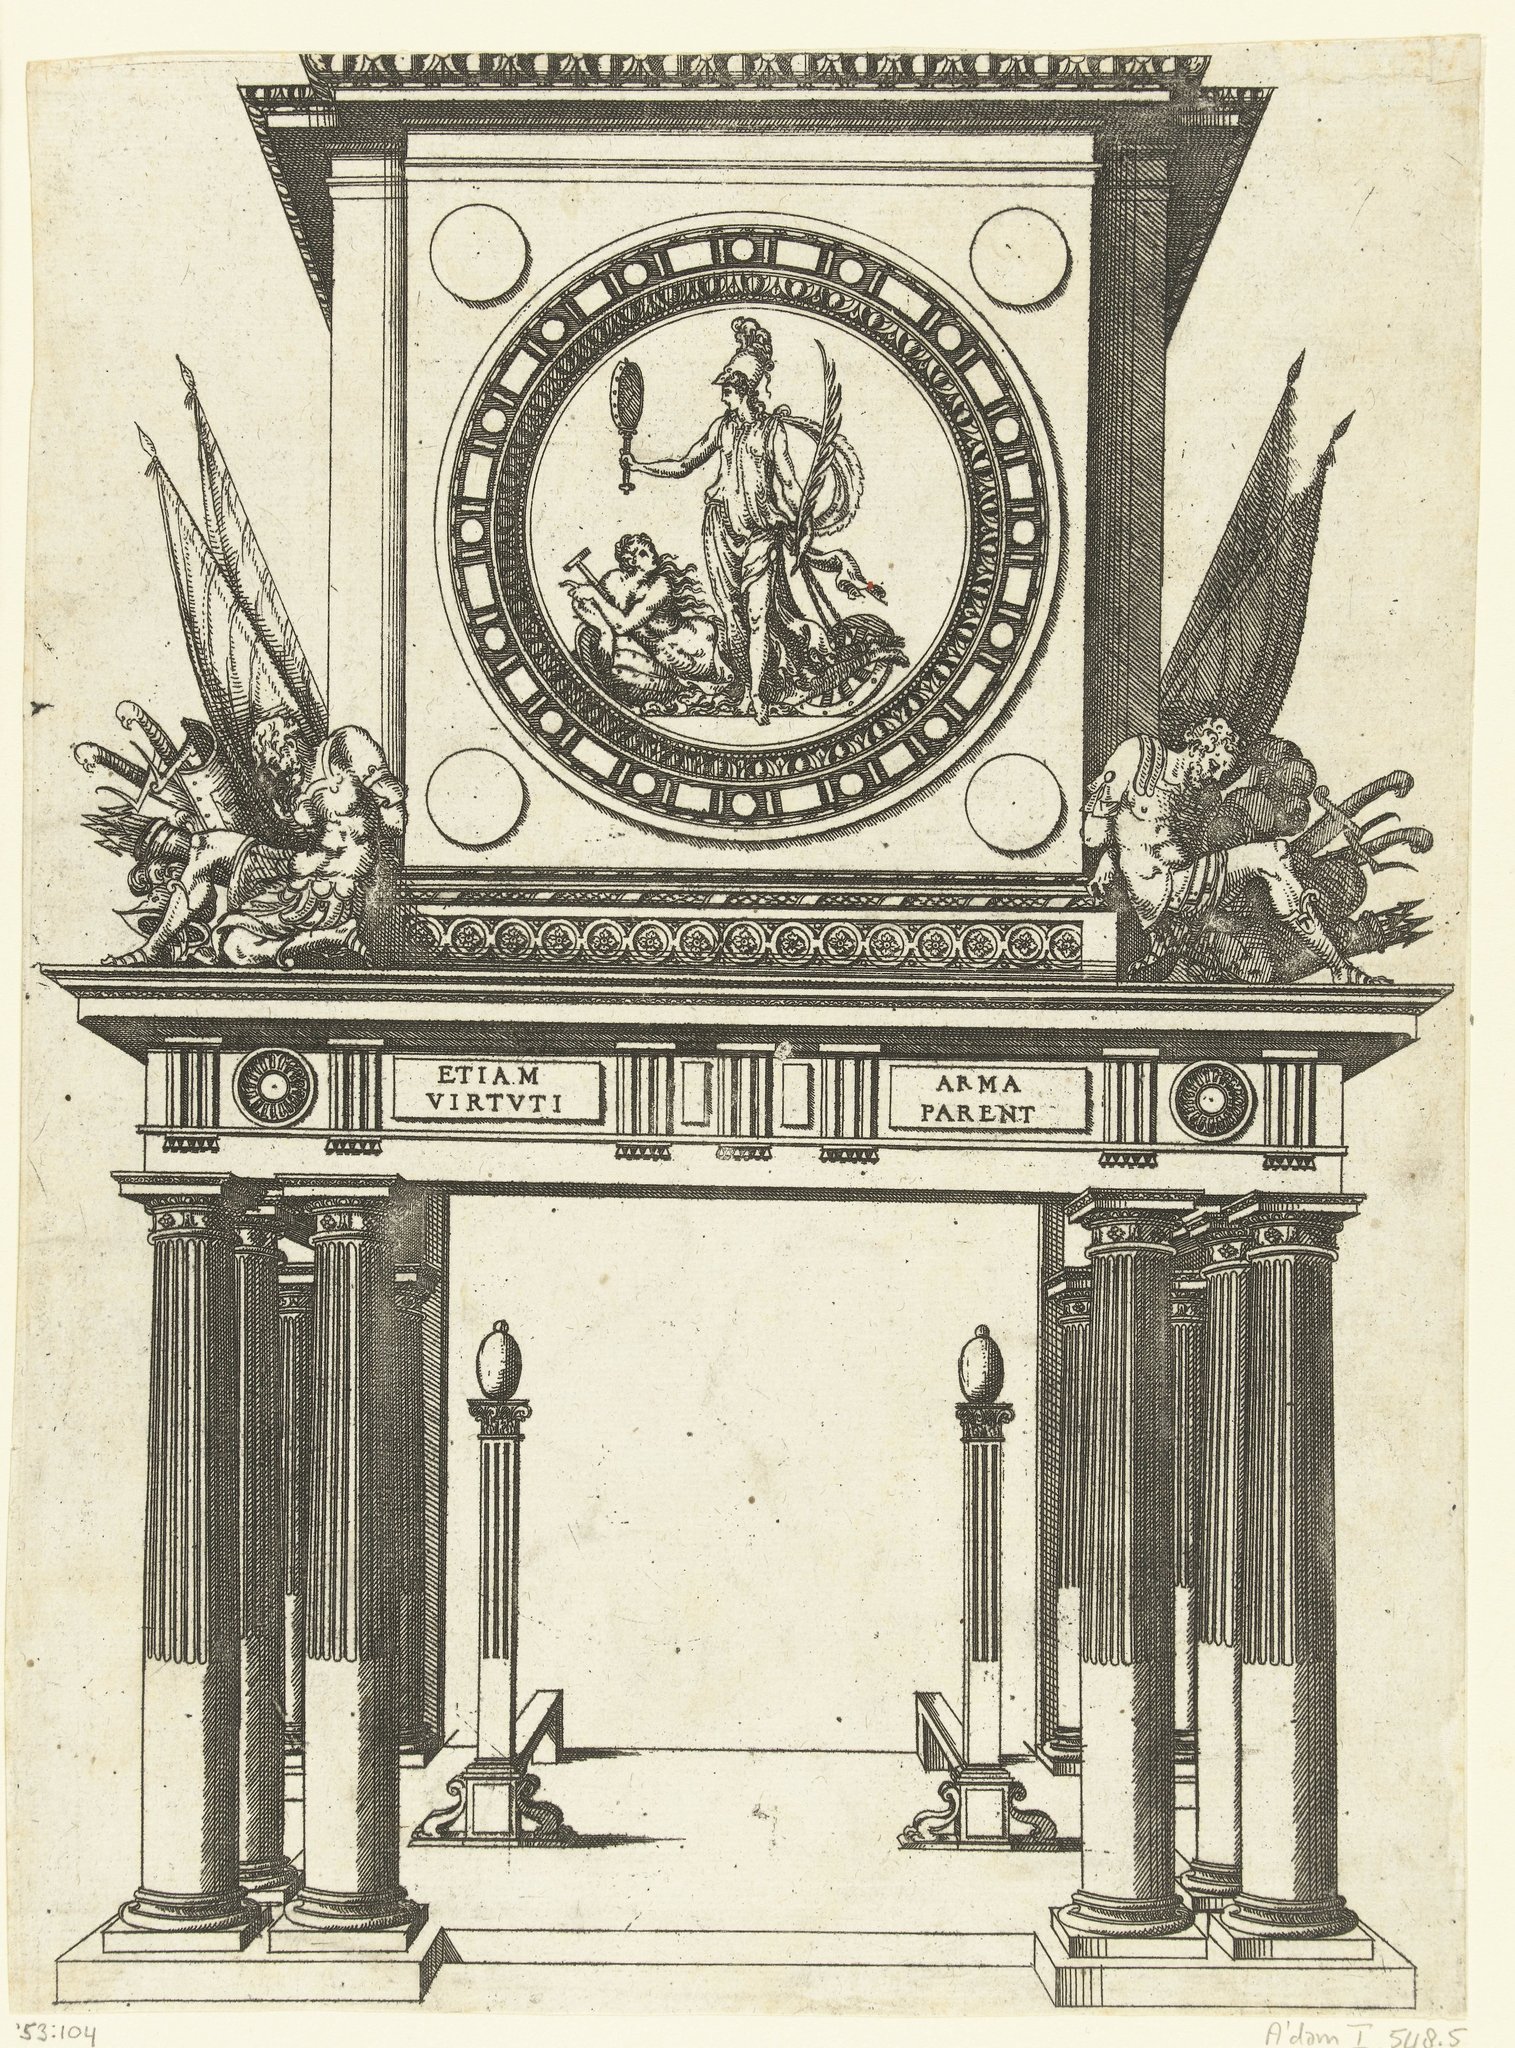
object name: ornament print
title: Blad uit de serie schoorstenen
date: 1520-1561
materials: paper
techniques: etching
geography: paris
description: Aan weerszijden van de mantel zit op de plaat een geboeide krijgsman bij wapens en vaandels. Uit een serie, bestaande uit een titelblad en 66 bladen met schoorsteenmantels, gedecoreerd met zuilen, hermen, cartouches, guirlandes en mascarons. Alle schoorsteenmantels zijn voorzien van haardijzers.